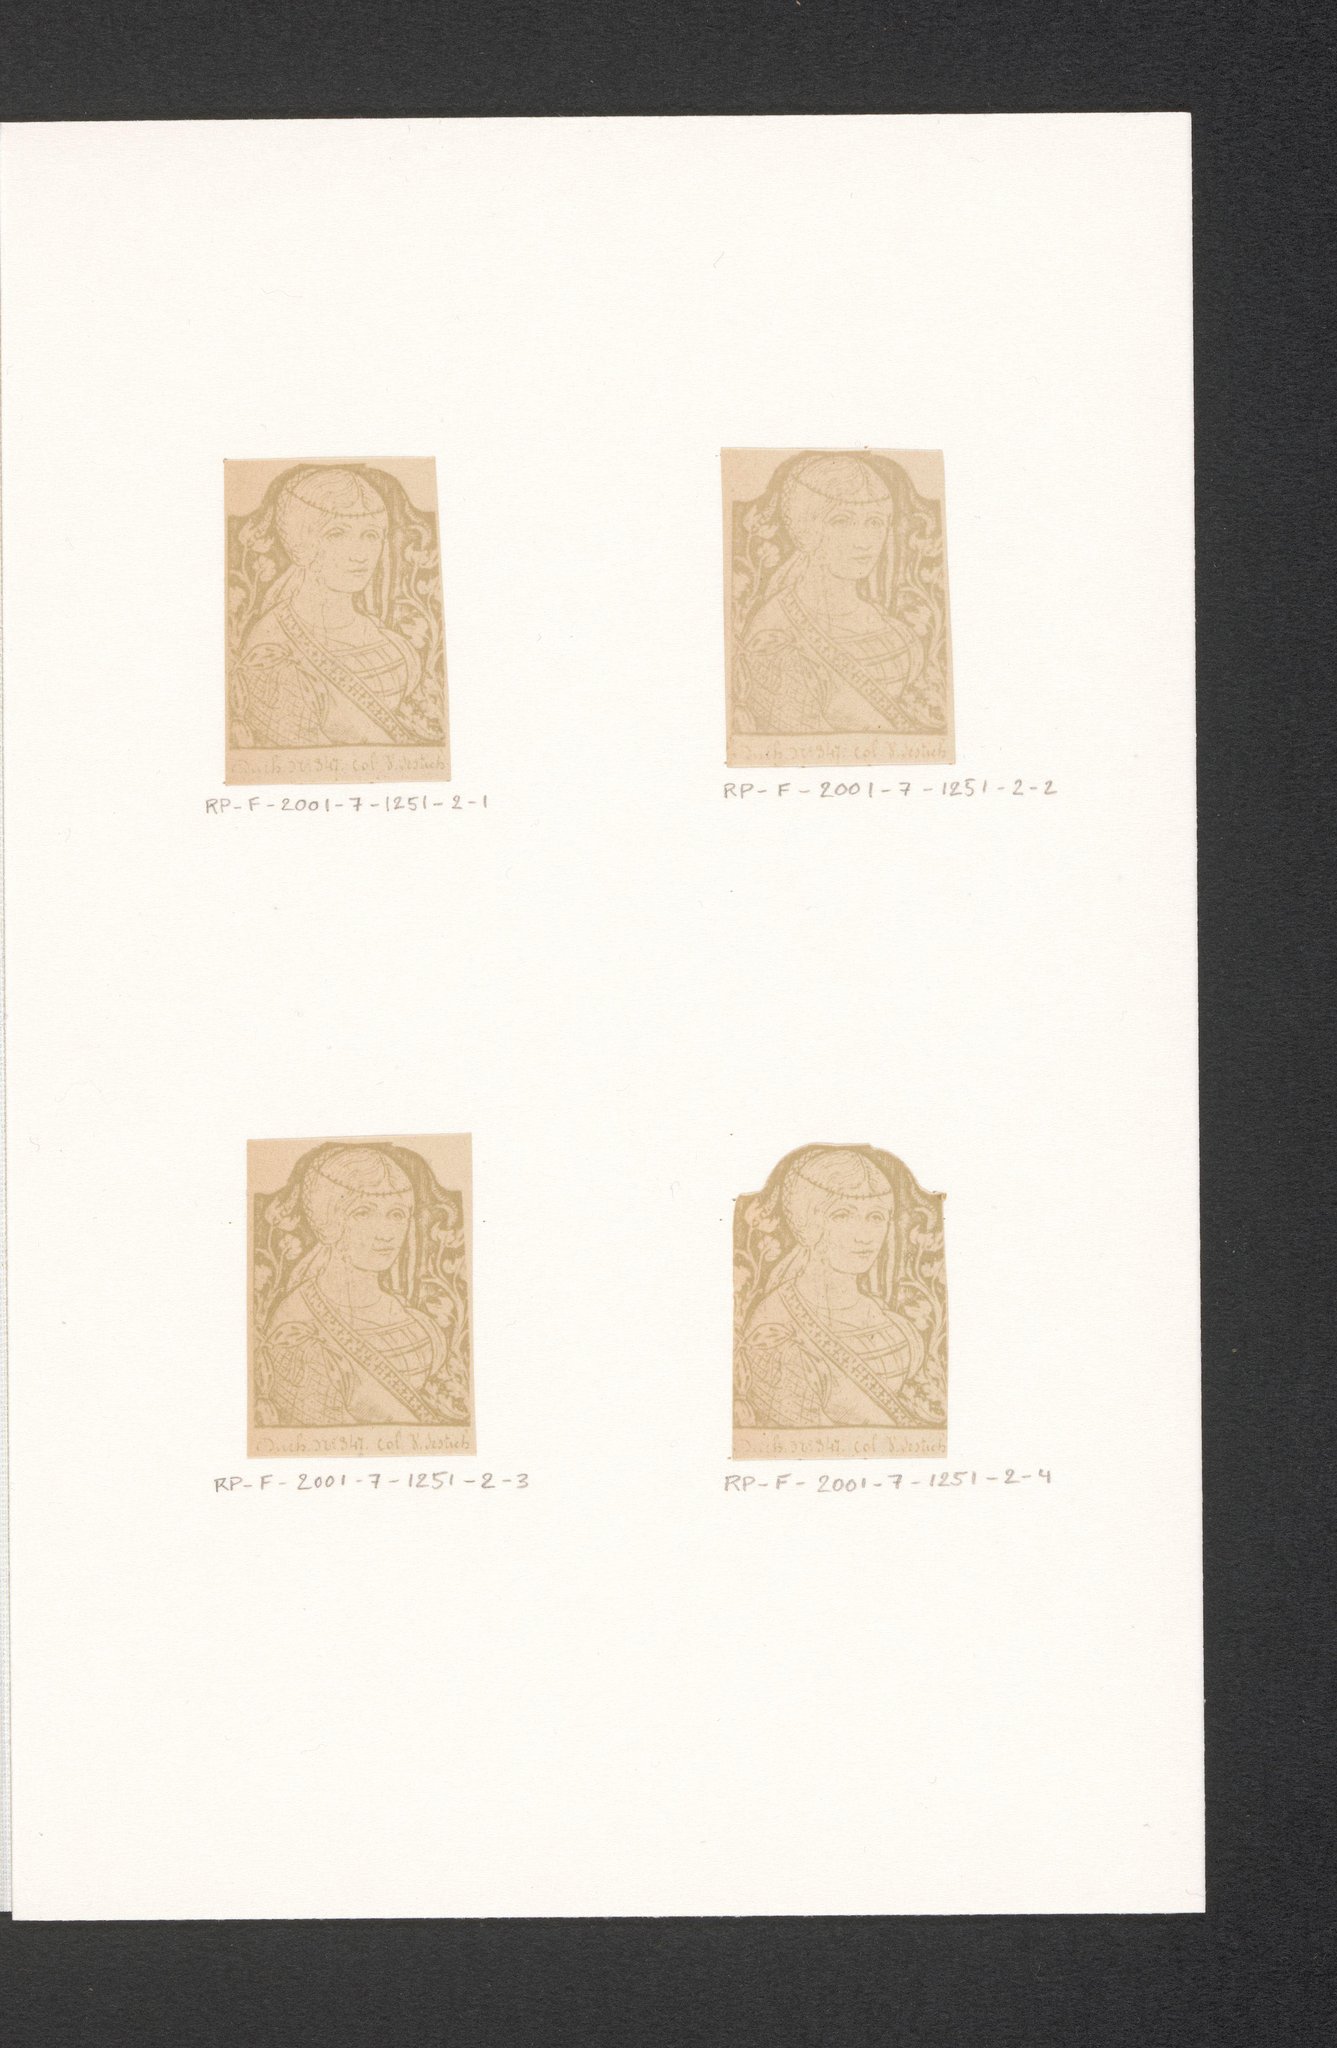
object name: photograph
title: Fotoreproductie van een prent van een portret van een onbekende vrouw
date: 1852-1857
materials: photographic support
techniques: salted paper print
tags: historical persons not known by name - bb - woman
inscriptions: inscription: ‘[Du]ch. No 347. col. V. Sestich’